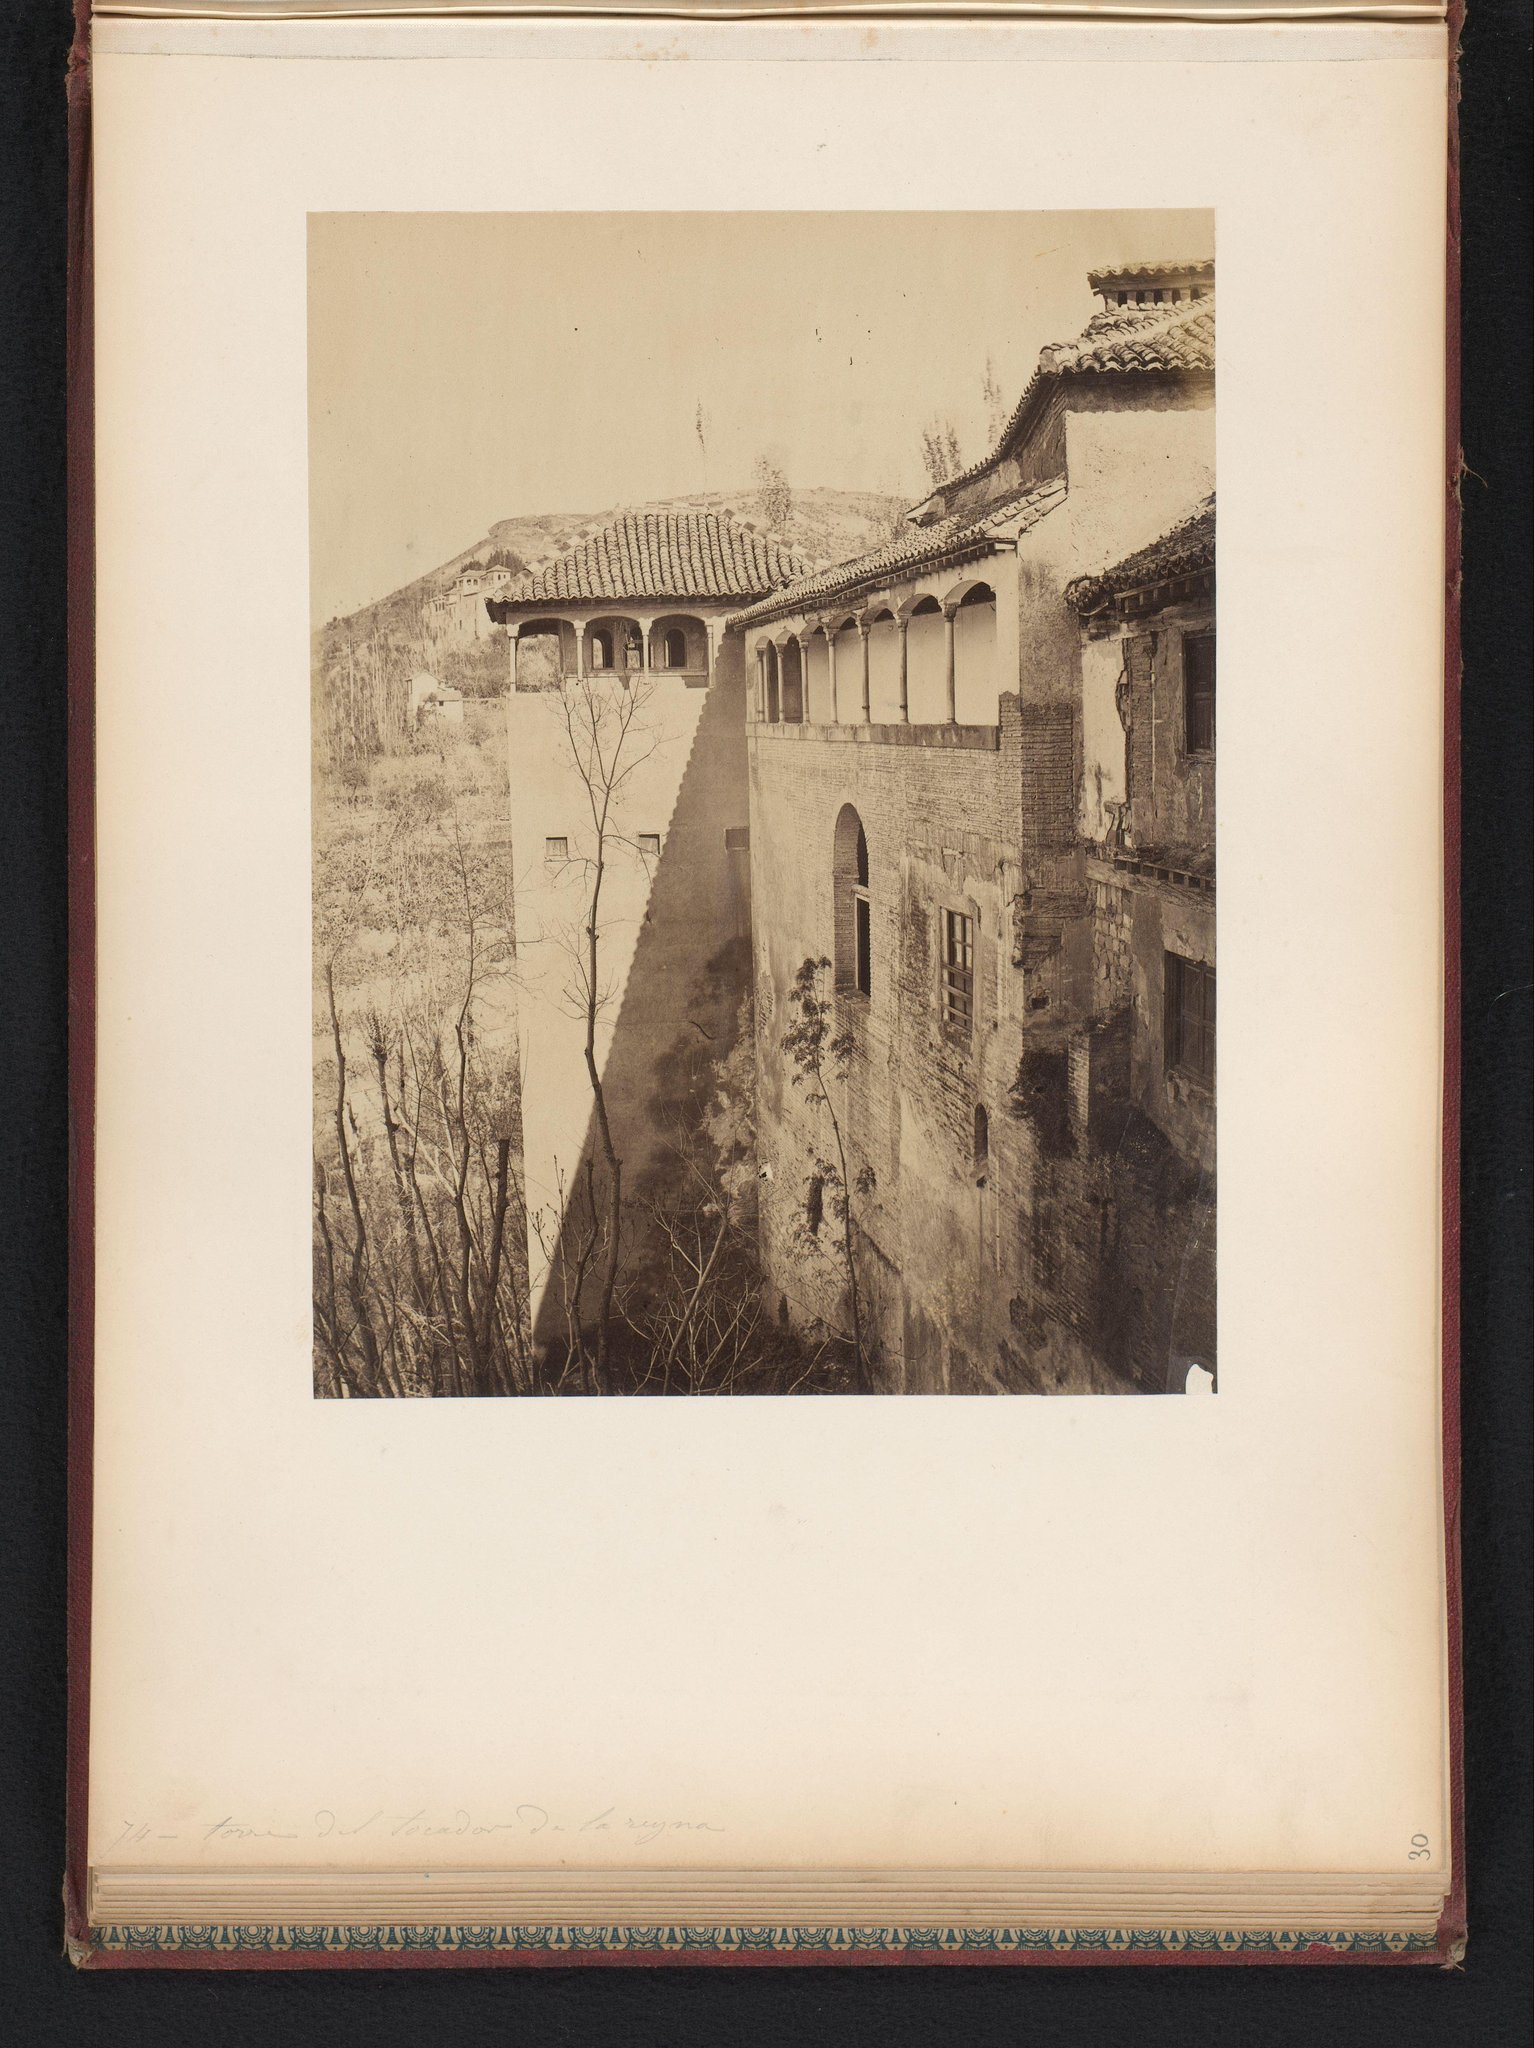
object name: photograph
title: Torre del Tocador de la Reyna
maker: c maufsaise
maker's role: fotograaf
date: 1906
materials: paper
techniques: albumen print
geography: granada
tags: palace, exterior ~ representation of a building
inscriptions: number: ‘74’